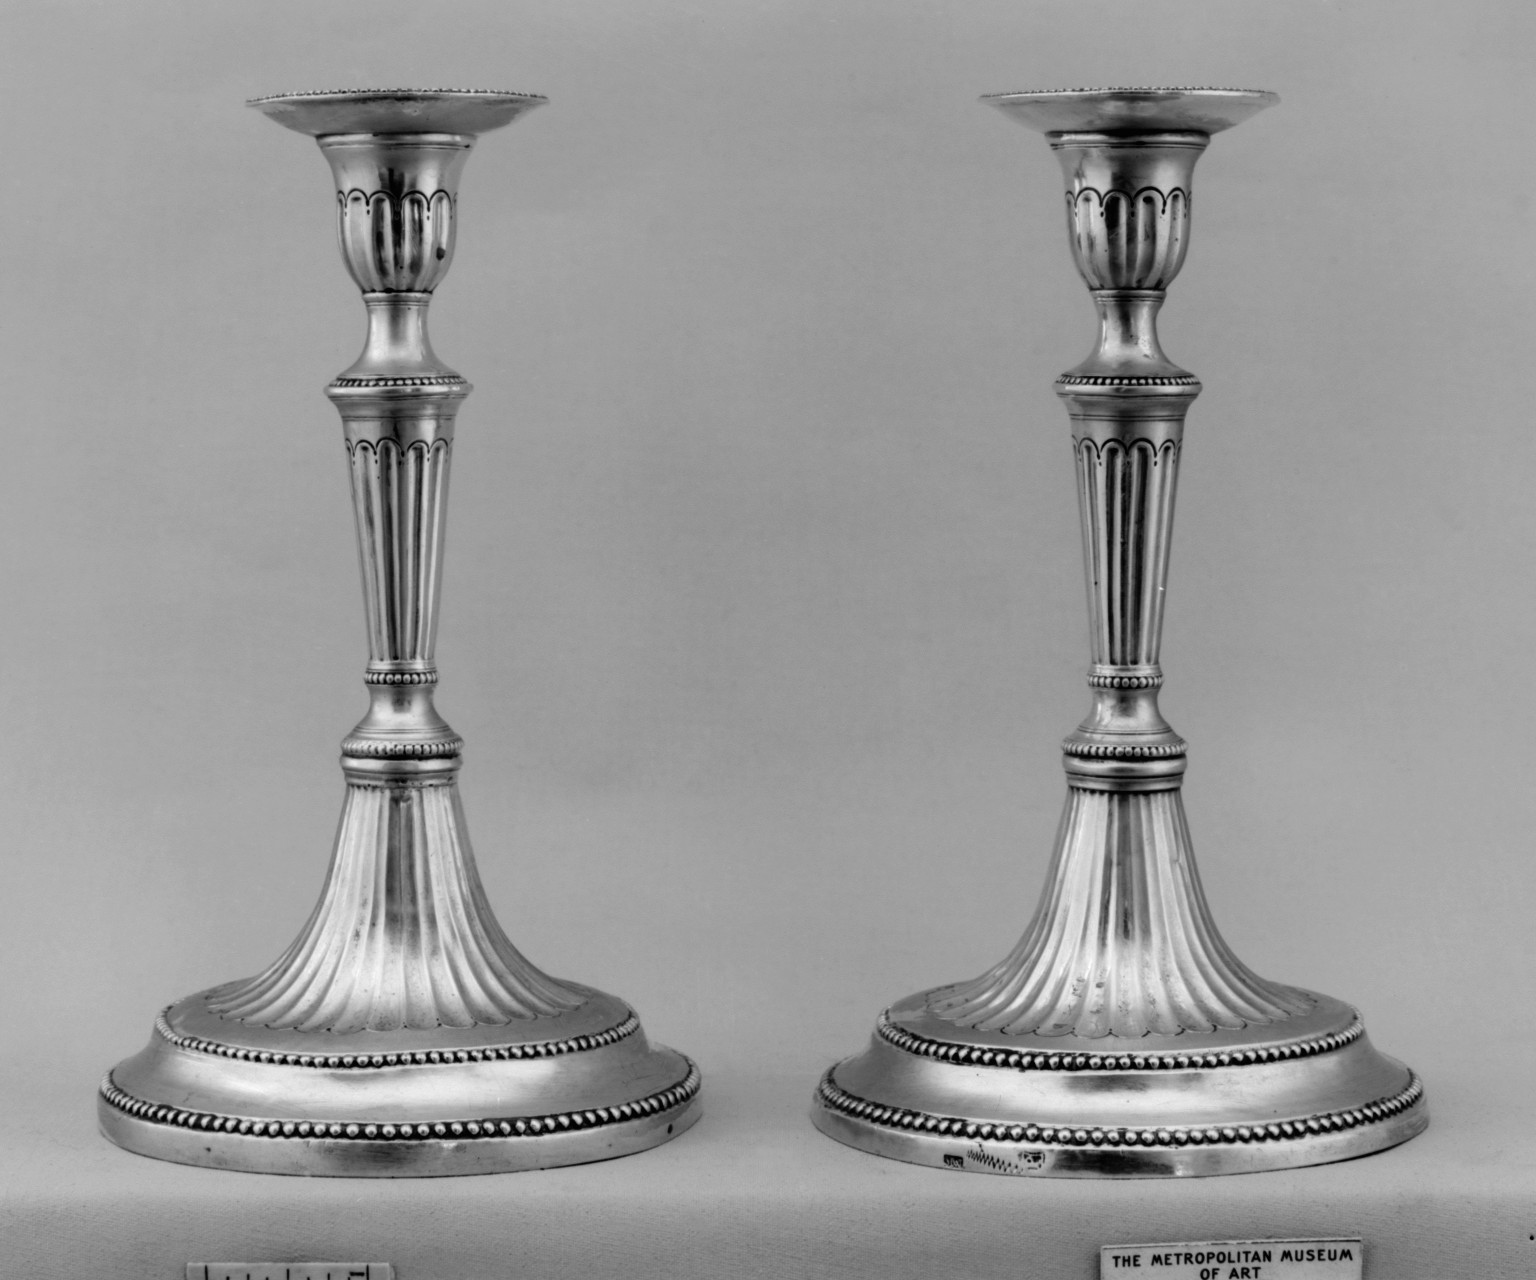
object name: candlestick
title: Candlestick (one of a pair)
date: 1776-1800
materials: silver